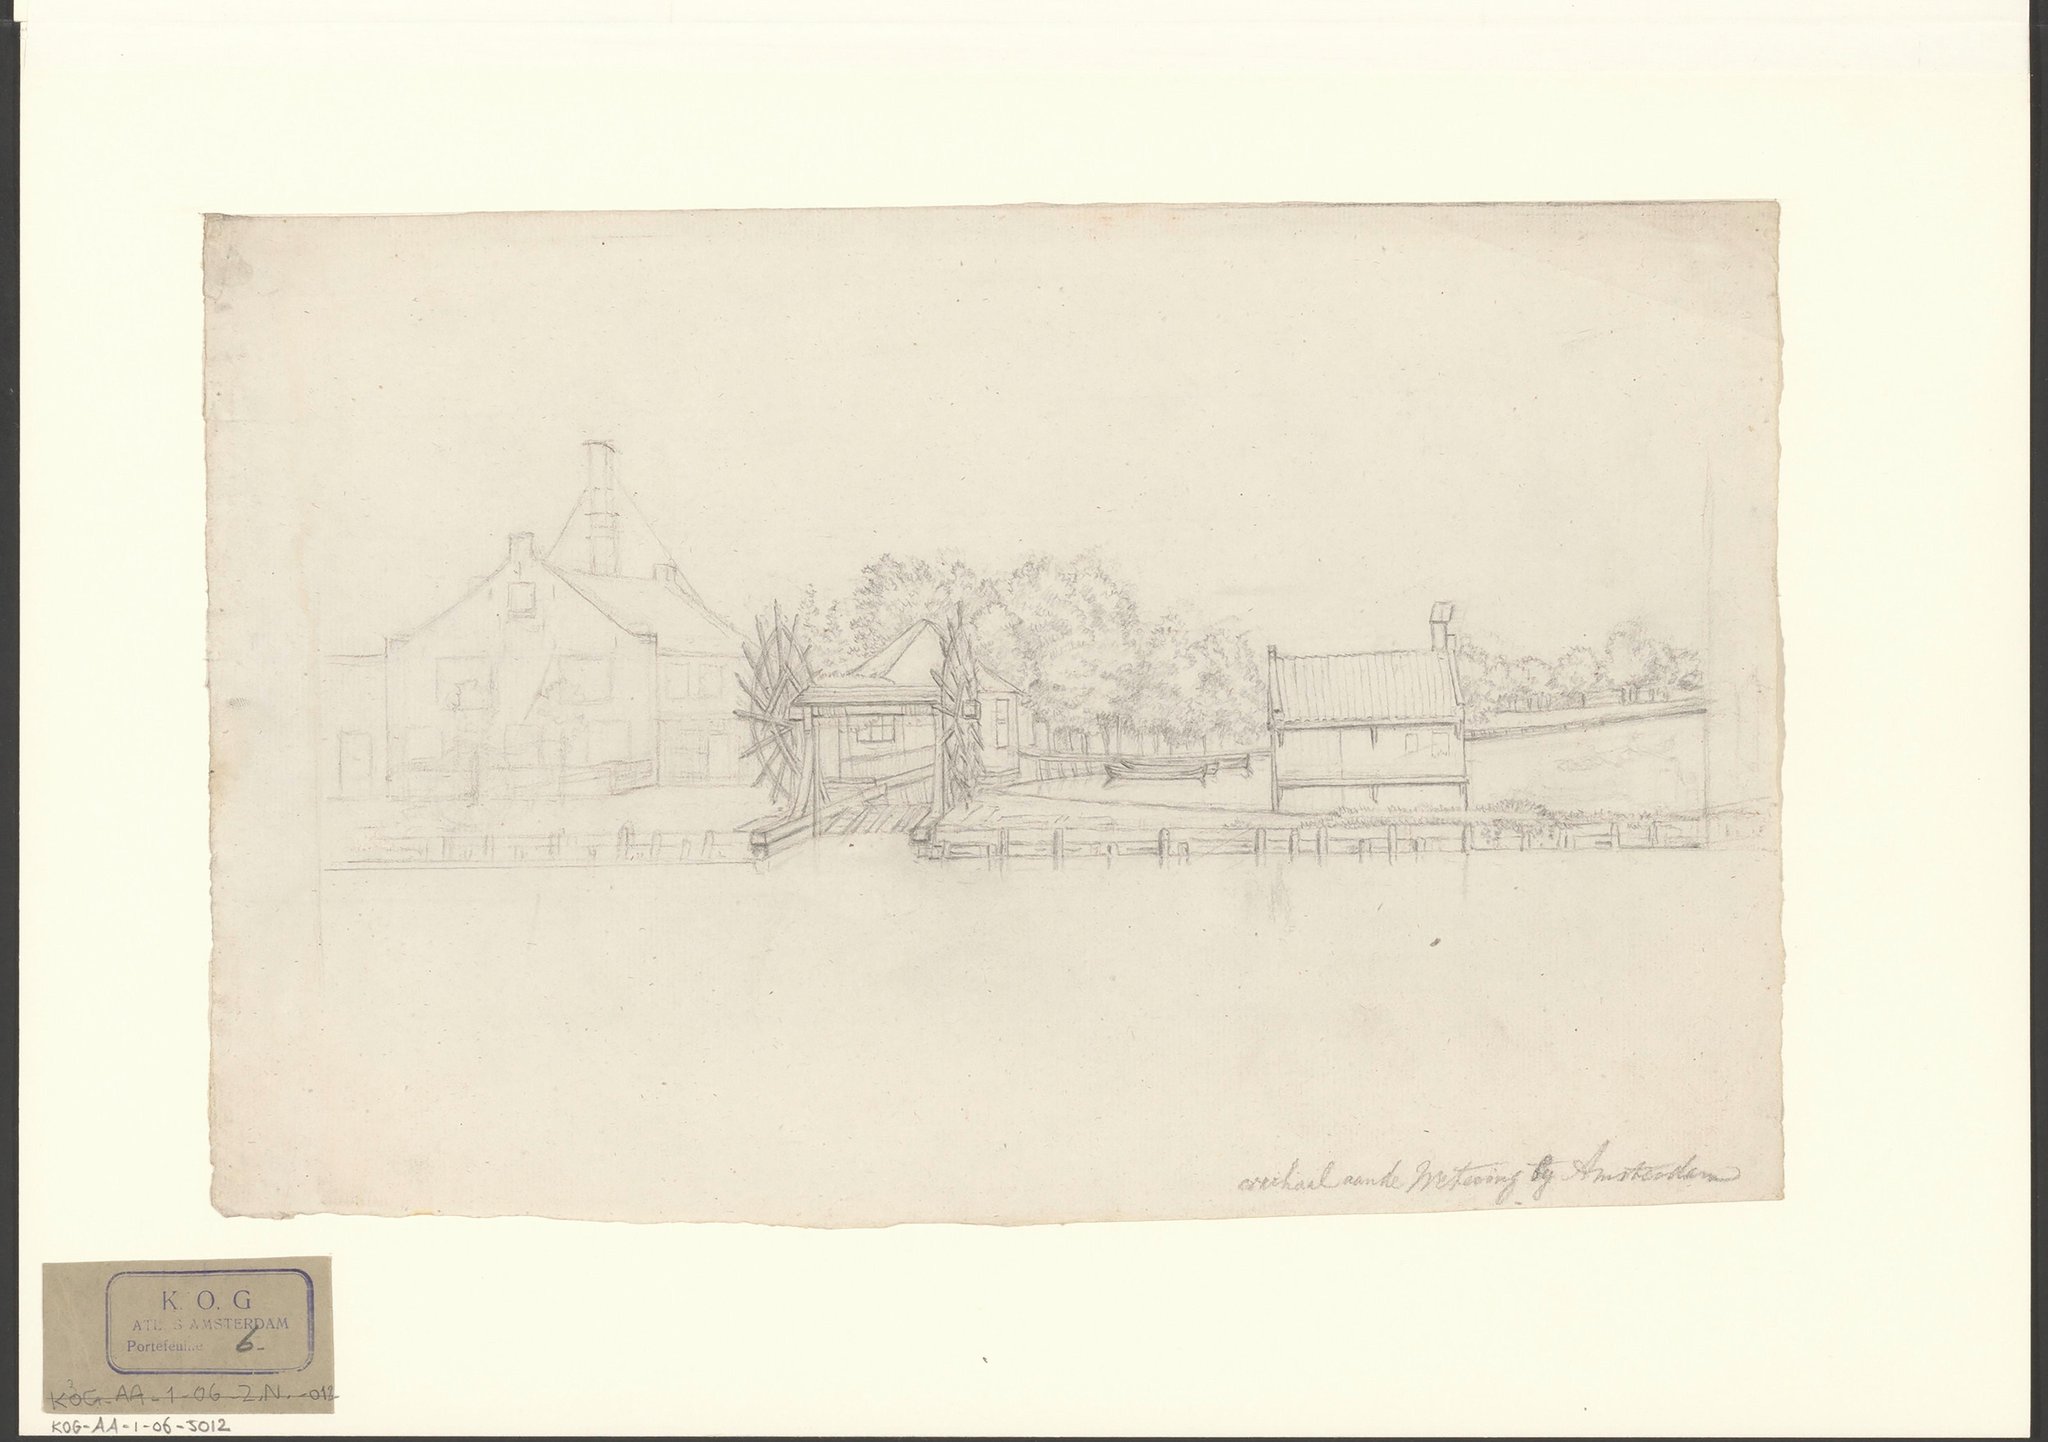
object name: drawing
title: Gezicht op de overhaal aan de Kostverloren Wetering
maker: Anonymous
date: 1800-1899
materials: paper, pencil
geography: amsterdam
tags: city-view in general; 'veduta', canal, rolling bridge (dutch: 'overtoom')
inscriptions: collector's mark: ‘6’ Lugt 1641b, inscription: ‘Port. 6’, inscription: ‘overhaal aan de Wetering by Amsterdam’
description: Onderwerpsrubriek binnen de Atlas Amsterdam: Buijskade, Catskade (Jacob), Clercqstraat (de), Commelinstraat, Costakade (da), Cuypstraat (Albert), Czaar Peterstraat.